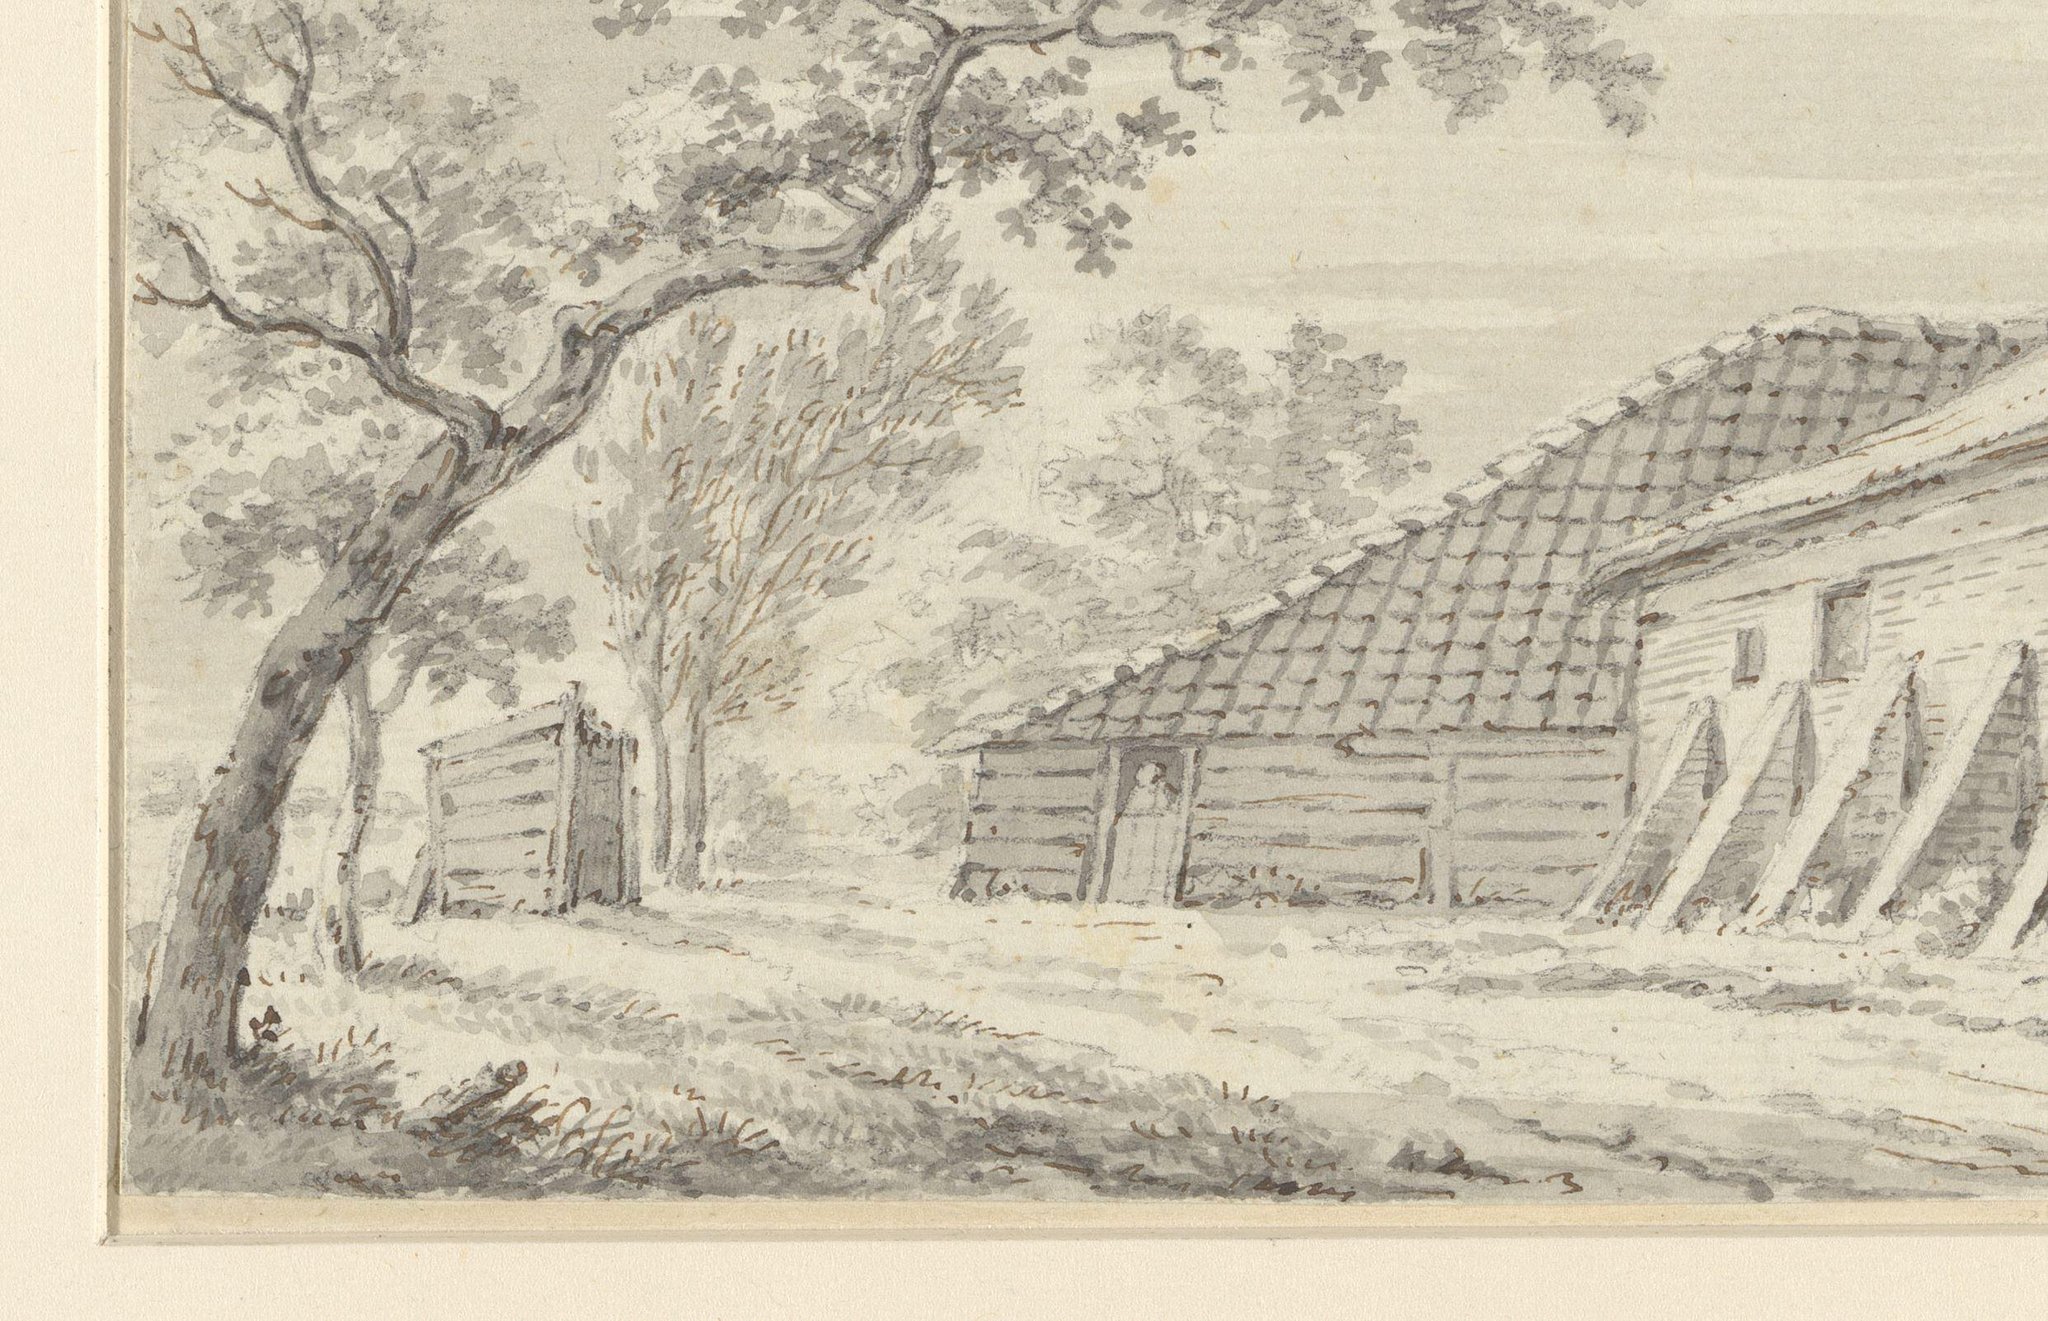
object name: drawing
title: Boerderij met schuur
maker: Anonymous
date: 1700-1800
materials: ink, paper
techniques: brush, pen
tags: farm or solitary house in landscape